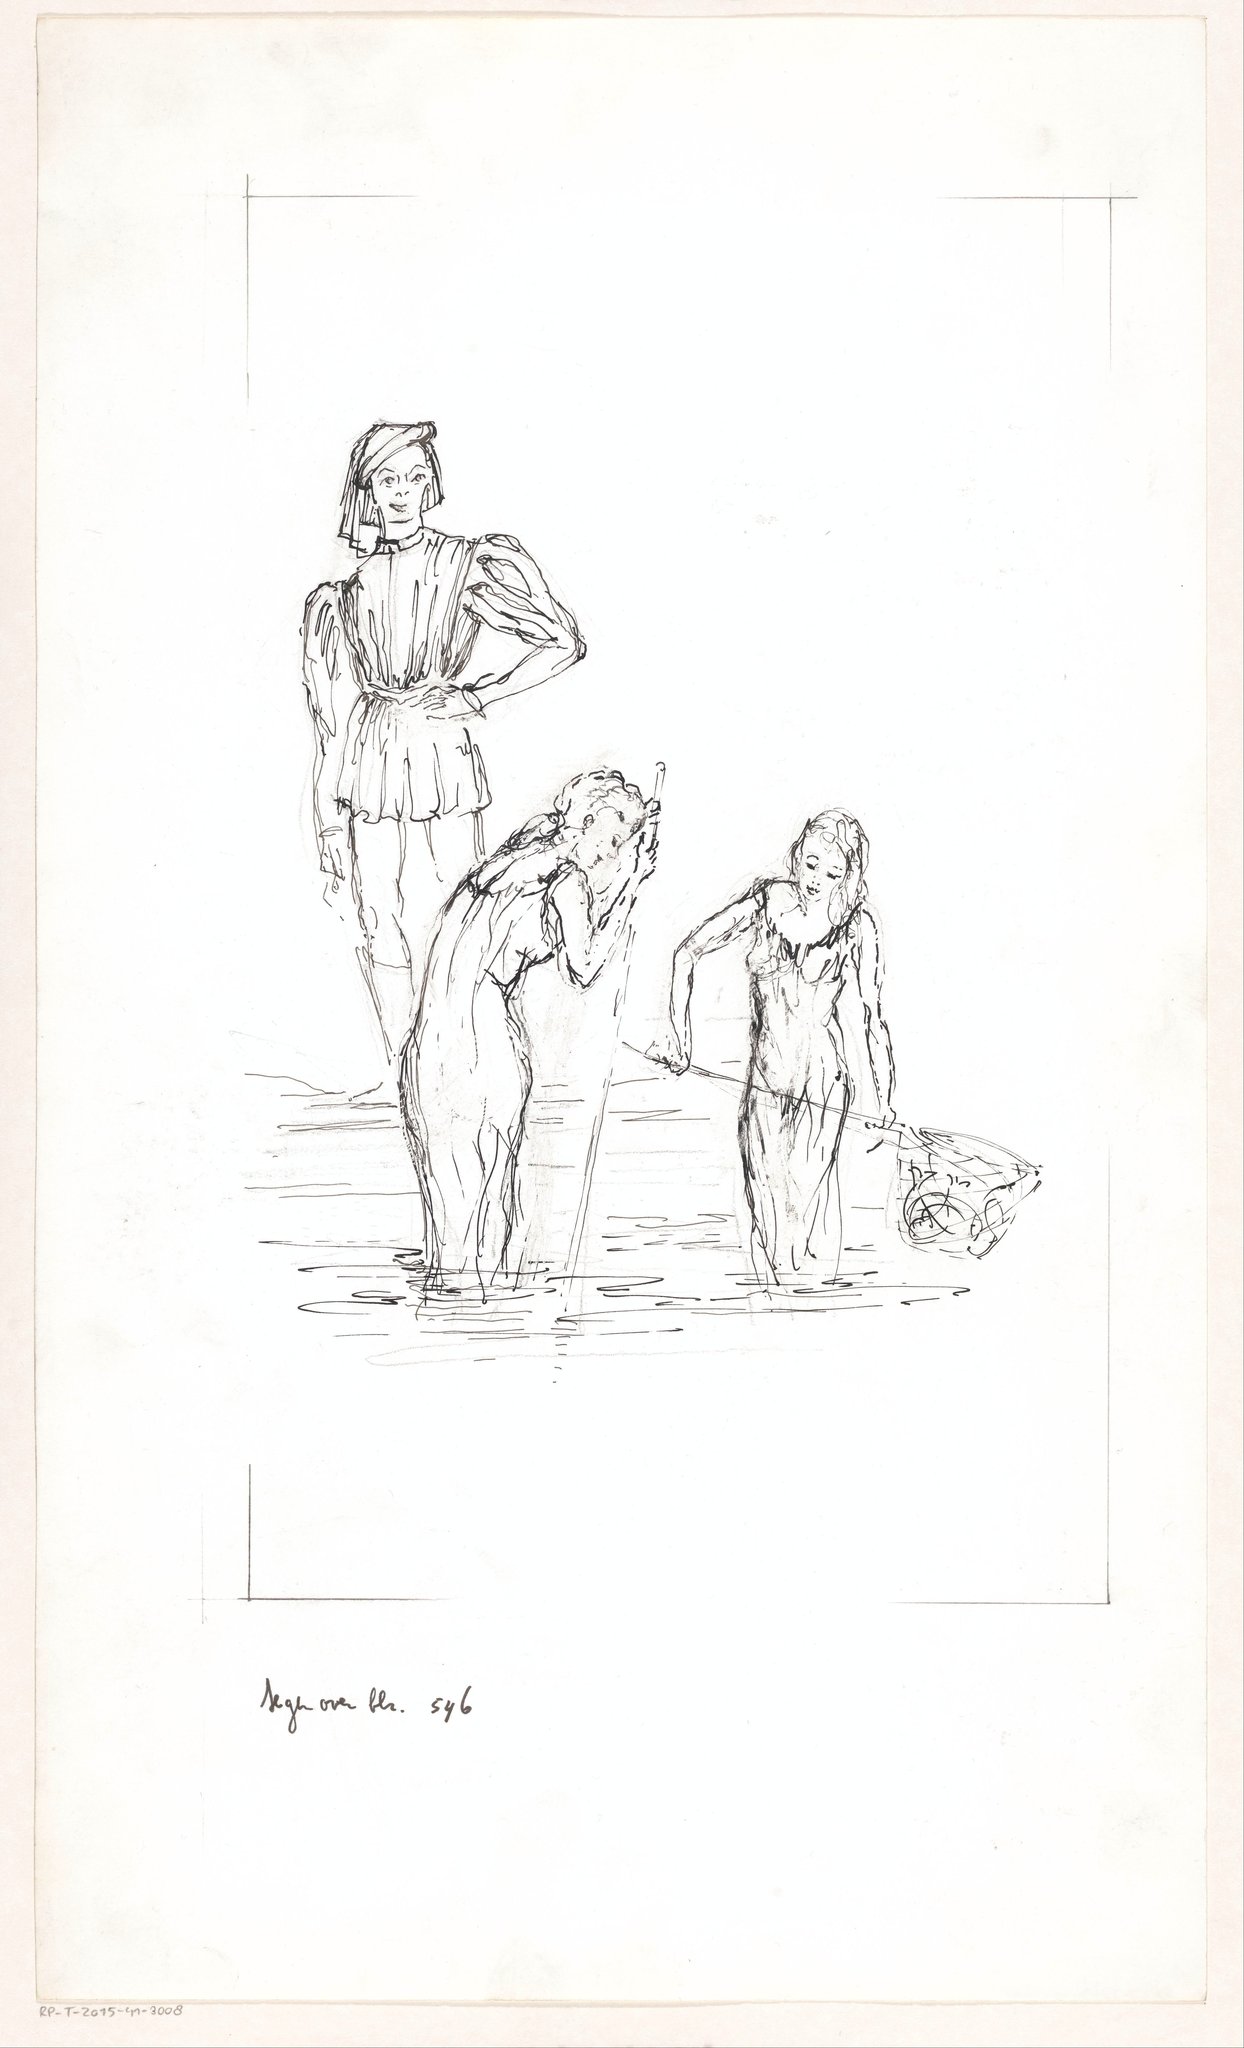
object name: boekillustratie ontwerp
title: Vrouwen vissen met schepnetten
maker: Anonymous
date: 1900-1970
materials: chalk, ink, paper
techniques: pen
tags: fishing net, historical costume, fisherman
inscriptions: collector's mark: Lugt 2228a, annotation: ‘tegen over blz. 546’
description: Twee vrouwen staan in laag water. Eén steunt op de stok van een schepnet, de ander houdt het gevulde schepnet boven het water. In de achtergrond kijkt een man toe. De man is gekleed in een tuniek met pofmouwen.